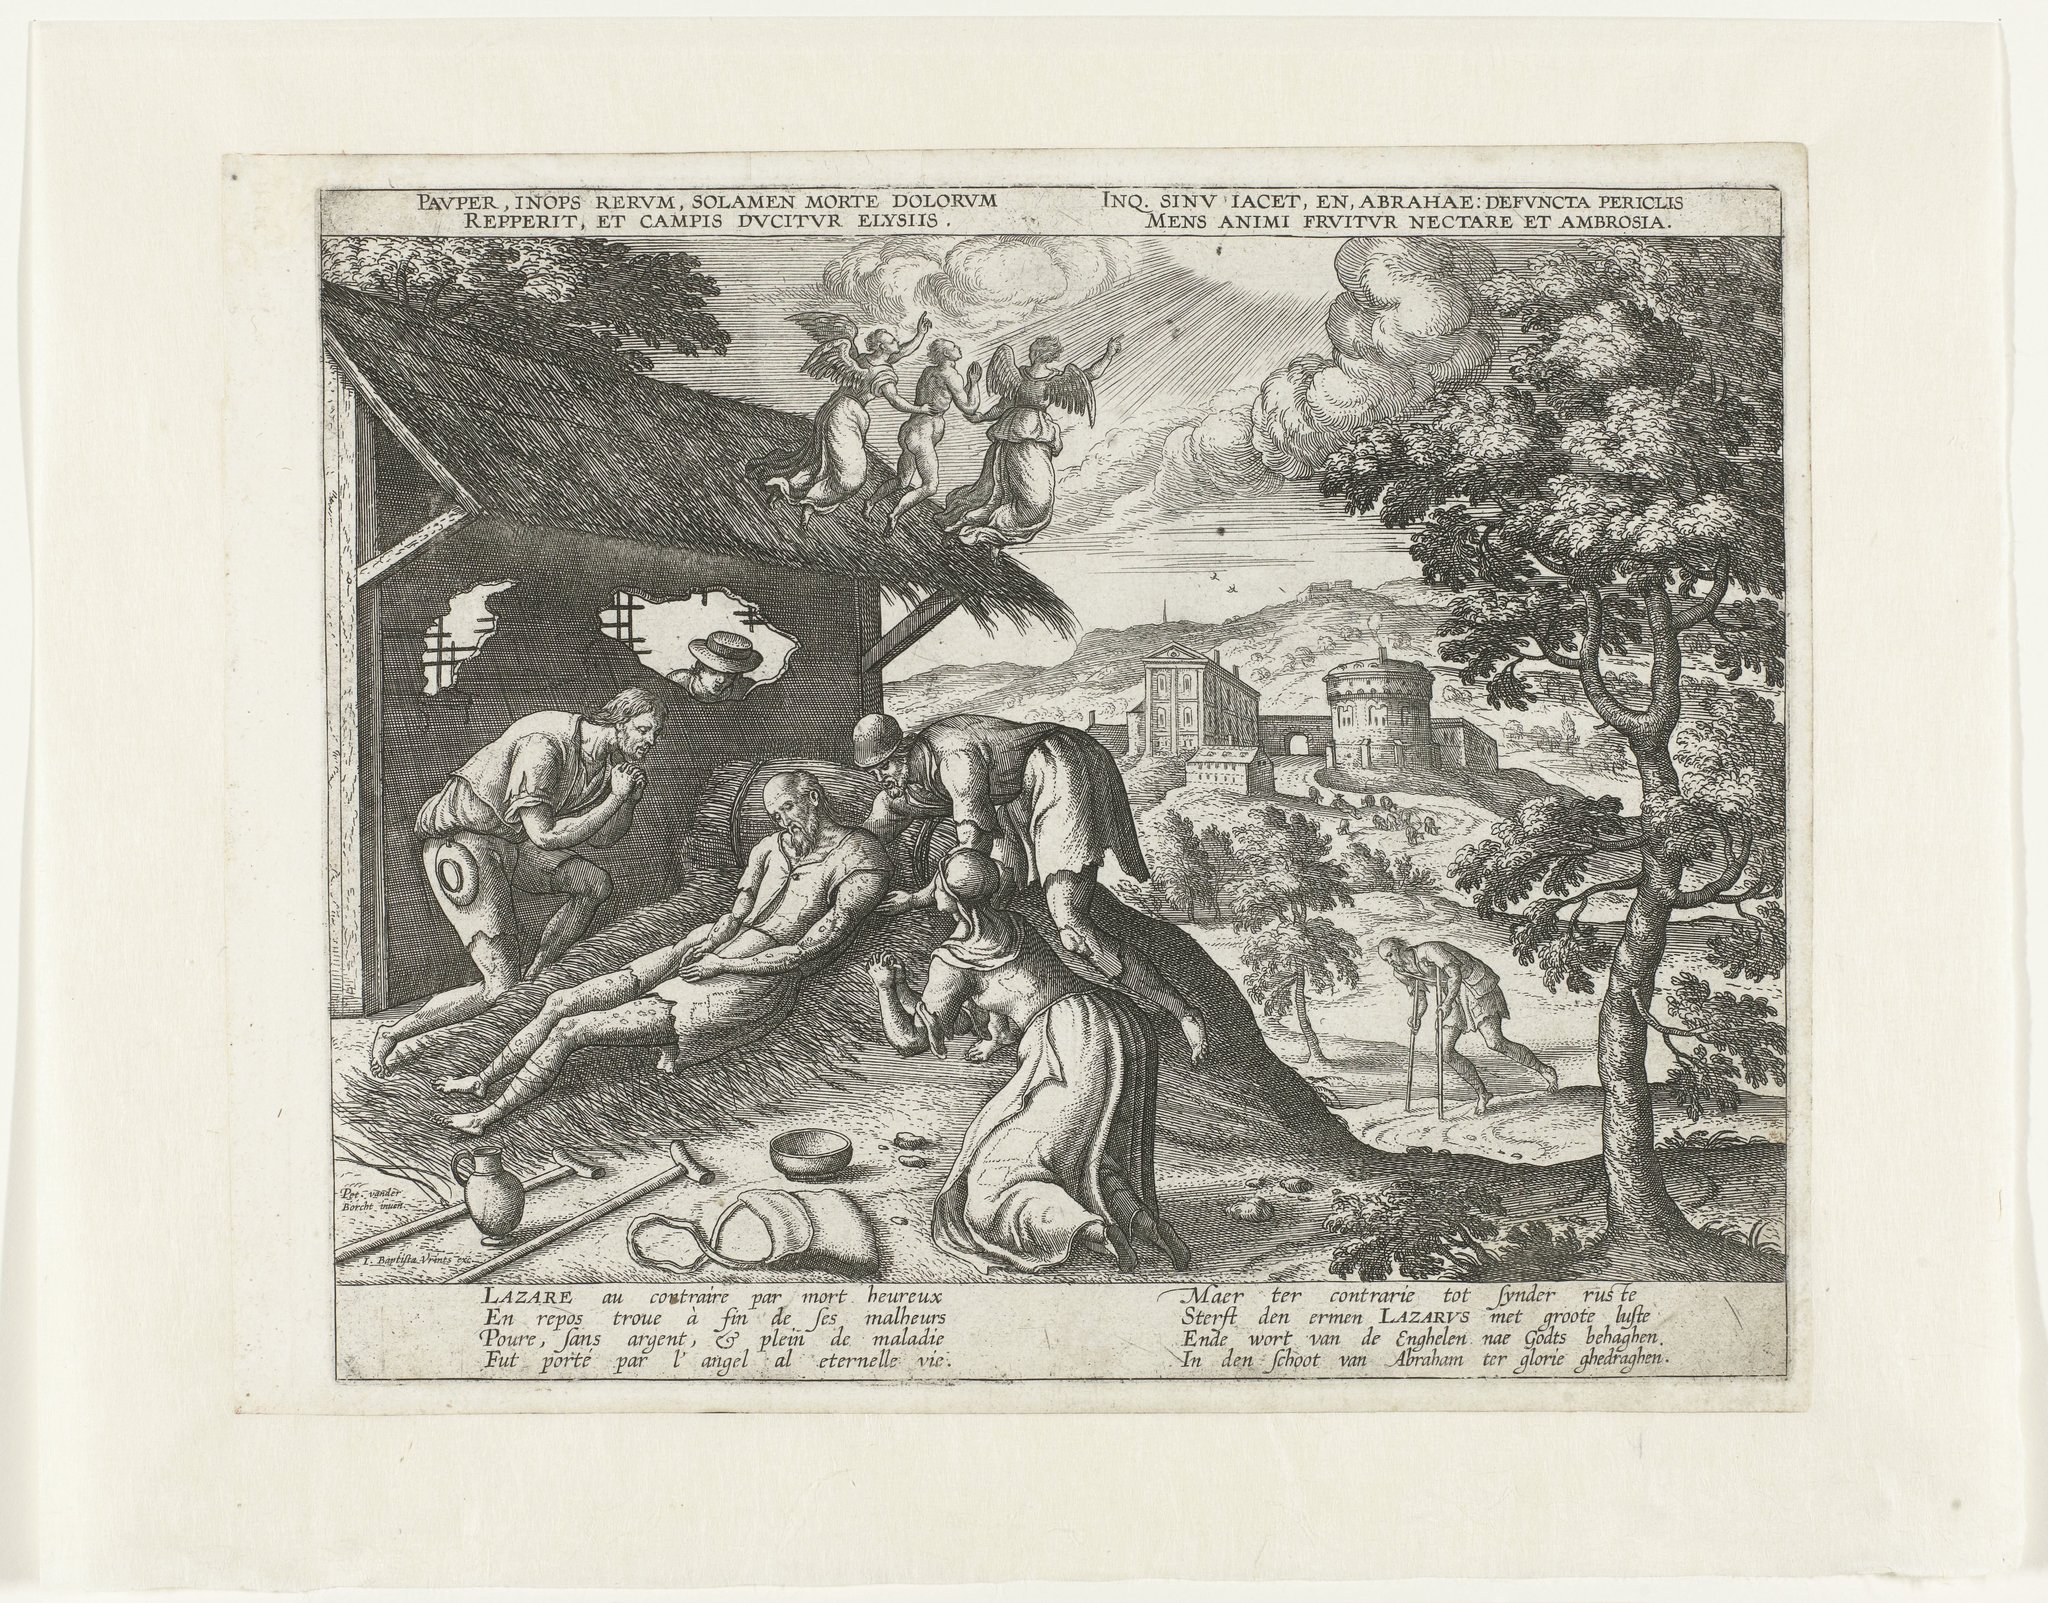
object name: print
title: De dood van de arme Lazarus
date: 1575-1599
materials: paper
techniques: engraving, etching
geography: antwerp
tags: lazarus dies: his soul is carried into abraham's lap by angels, crutches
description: De arme Lazarus ligt dood op een strobed onder een afdakje. Hij wordt beweend door drie figuren. In de lucht drie engelen die zijn ziel naar de hemel voeren. Rechts op de achtergrond Lazarus als kreupele man, lopend op krukken in landschap. Met bovenschrift in het Latijn en onderschriften in het Frans en Nederlands.